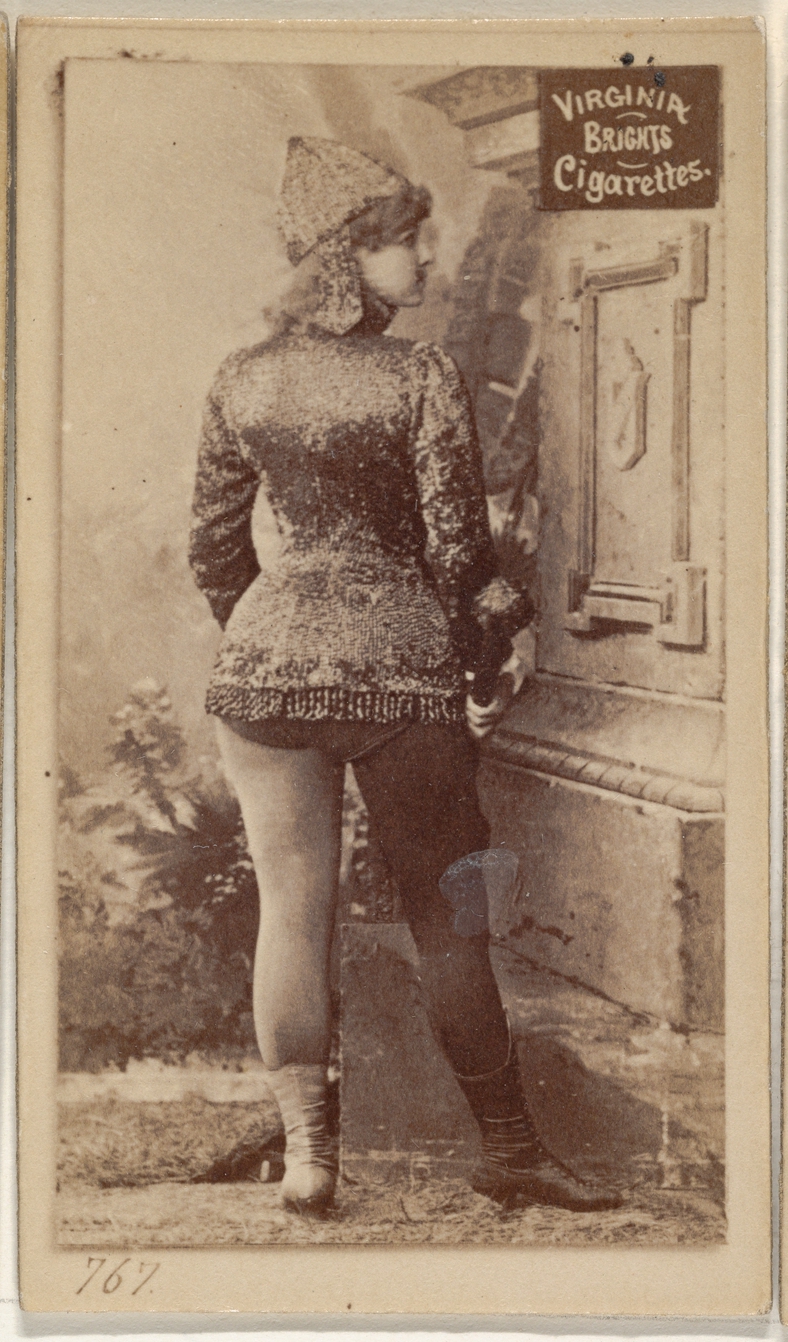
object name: photograph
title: Card 767, from the Actors and Actresses series (N45, Type 2) for Virginia Brights Cigarettes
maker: allen & ginter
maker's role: publisher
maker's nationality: american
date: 1888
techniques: albumen silver print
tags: portraits,profiles,women,actresses